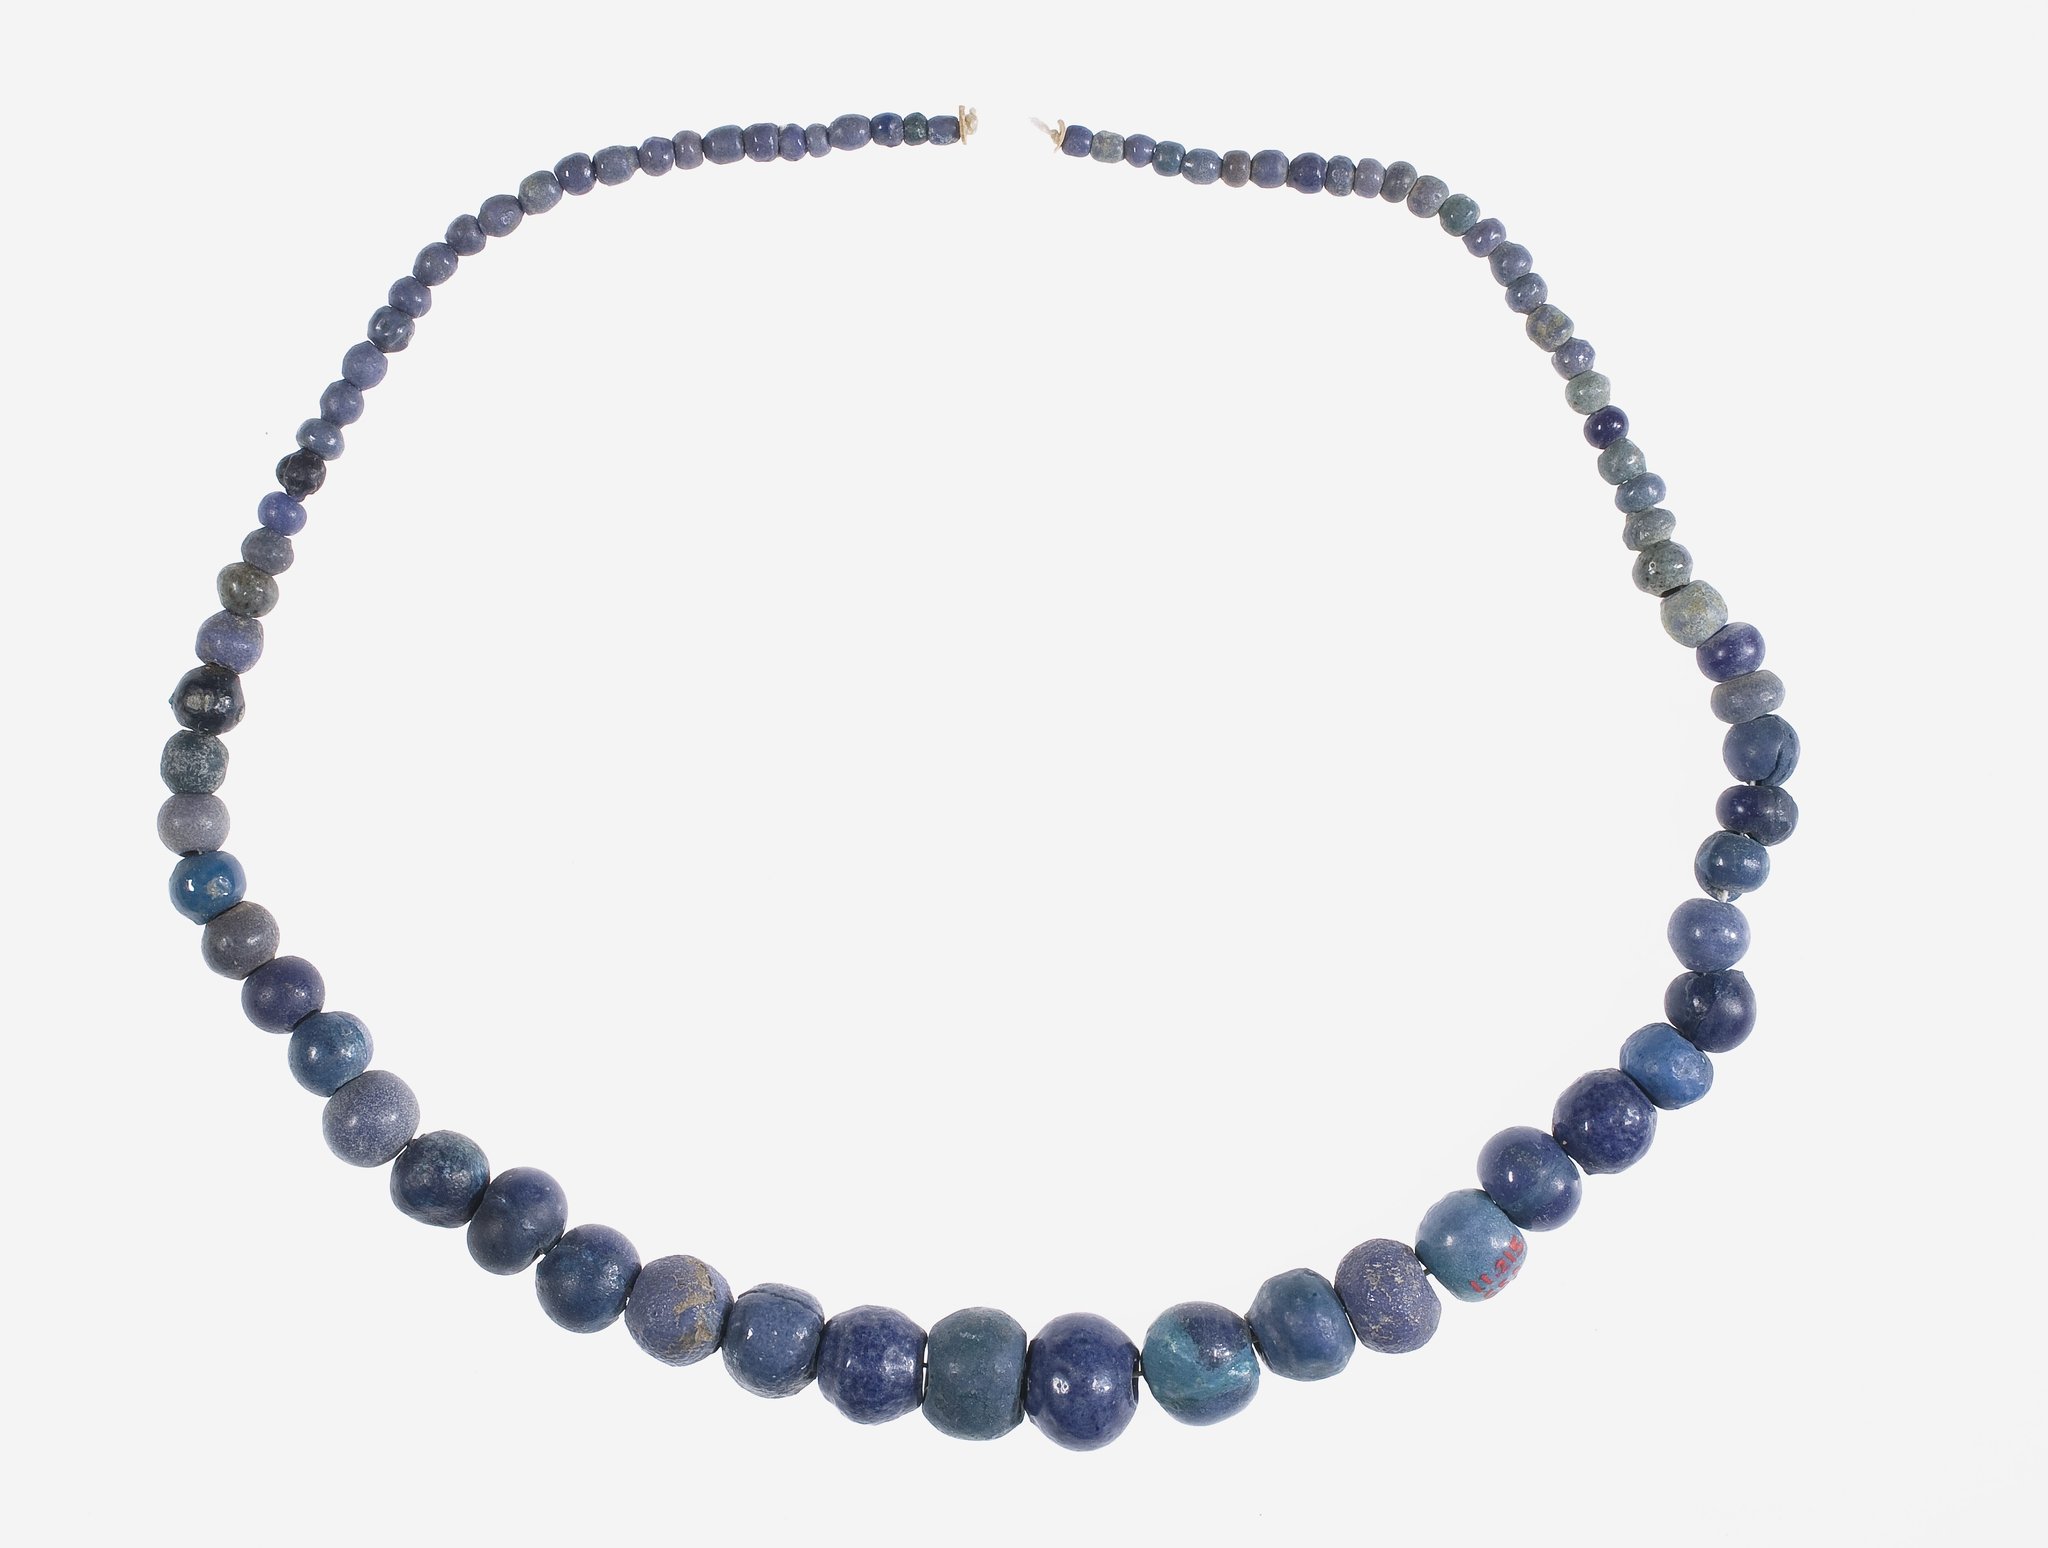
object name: bead, ball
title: String of Ball Beads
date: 1390-1352 BCE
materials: glass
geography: egypt